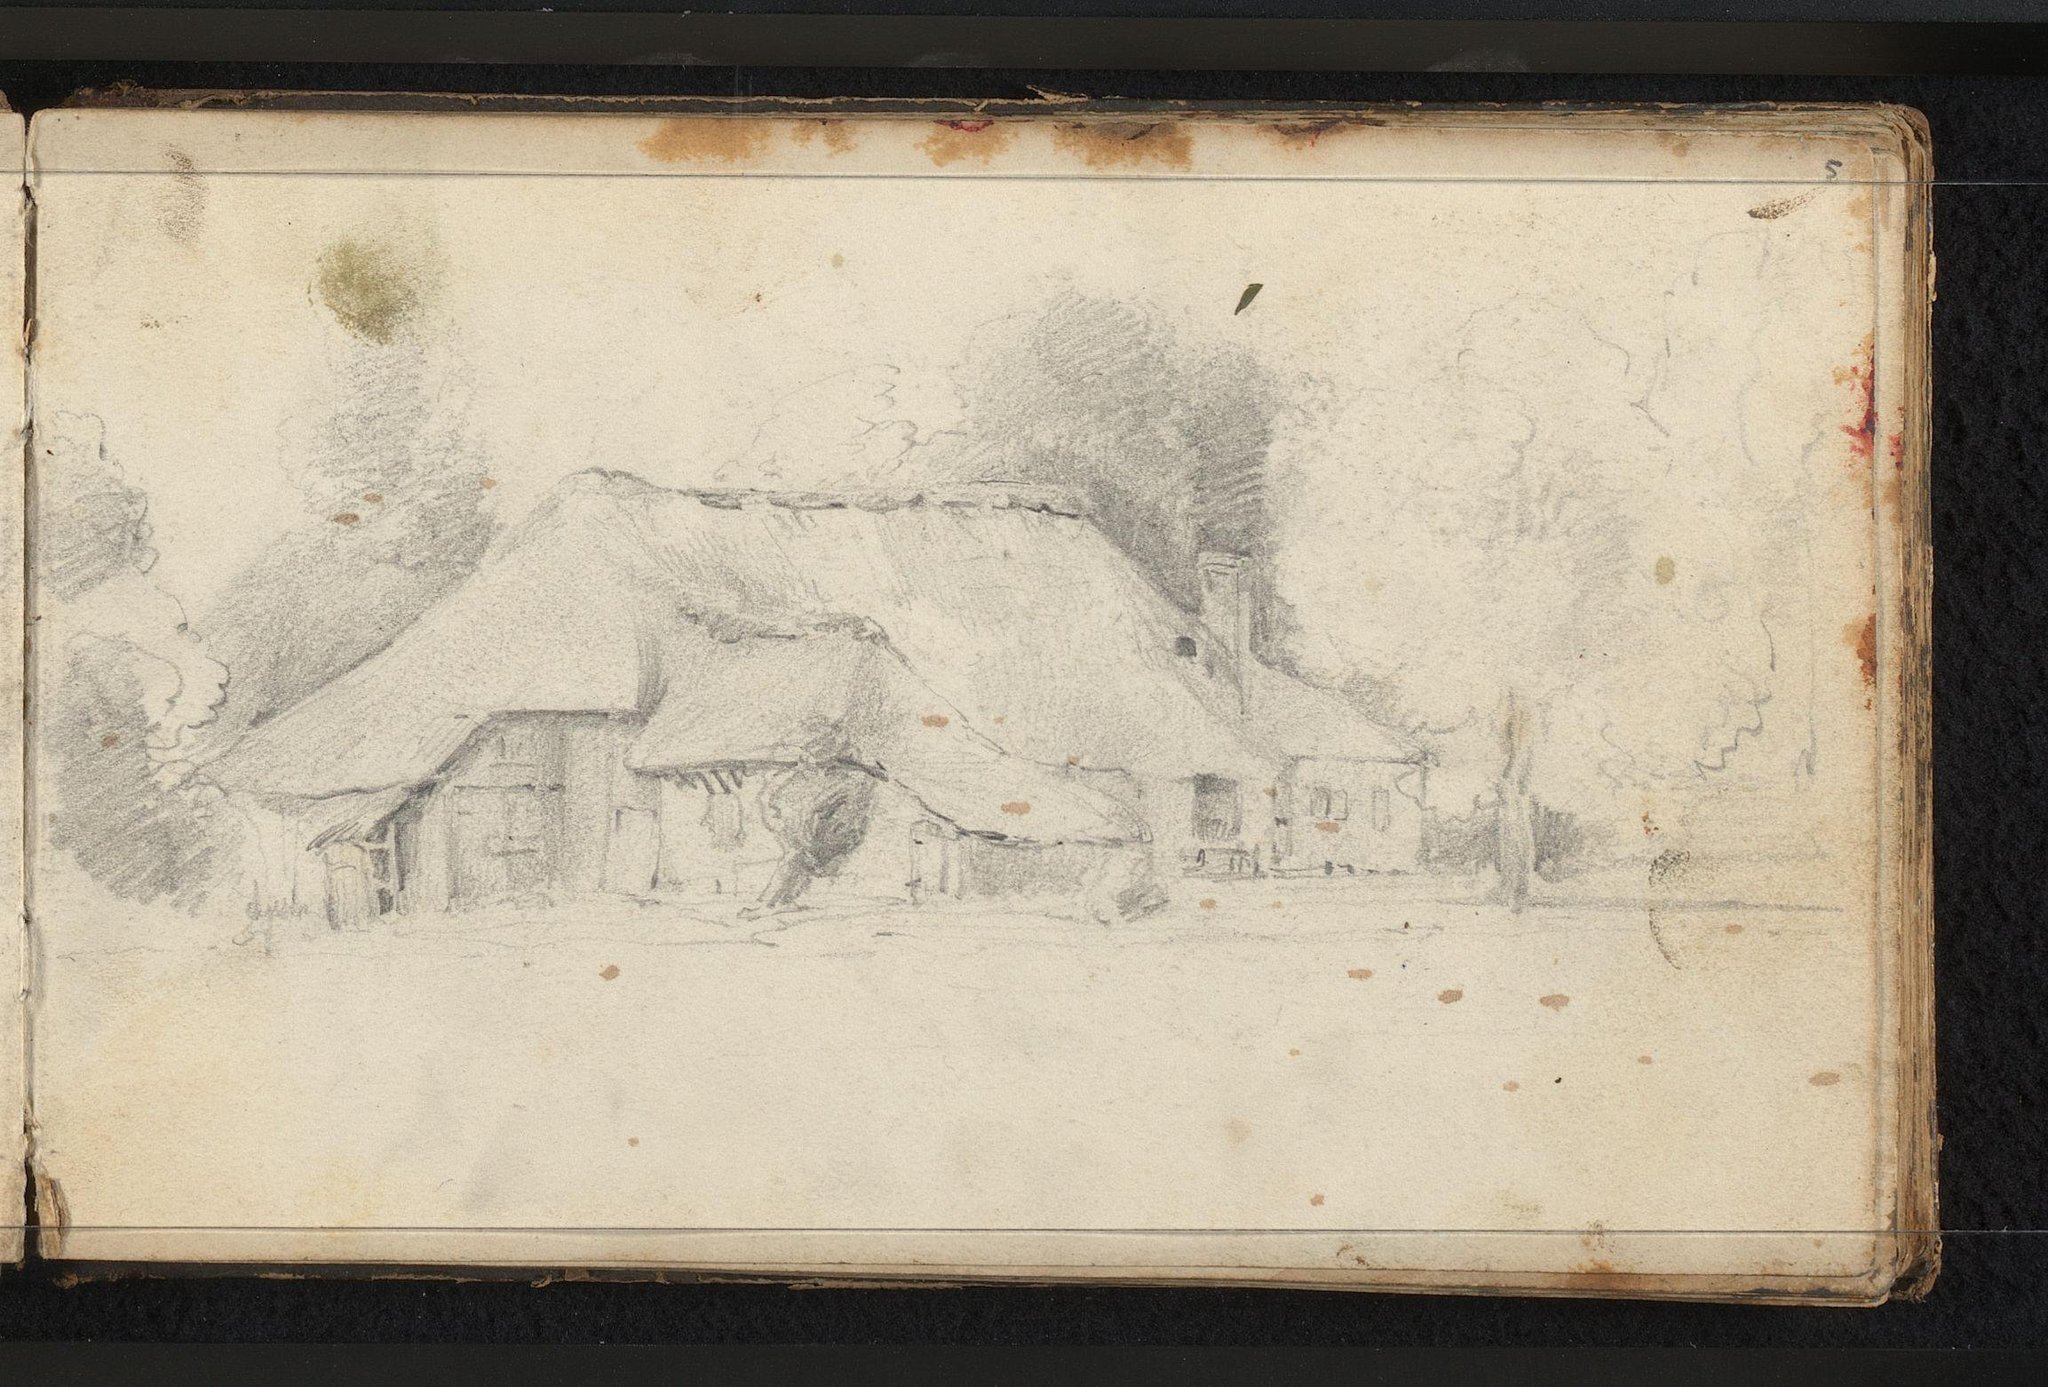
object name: sketchbook leaf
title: Boerderij omgeven door bomen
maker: jan bedijs tom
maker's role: draughtsman, painter, print maker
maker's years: 1813-1894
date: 1828-1894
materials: paper, pencil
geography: the hague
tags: trees, landscapes, artist (in general) making preliminary designs, sketching, farm or solitary house in landscape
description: Pagina 5 recto uit een schetsboek met 54 bladen.